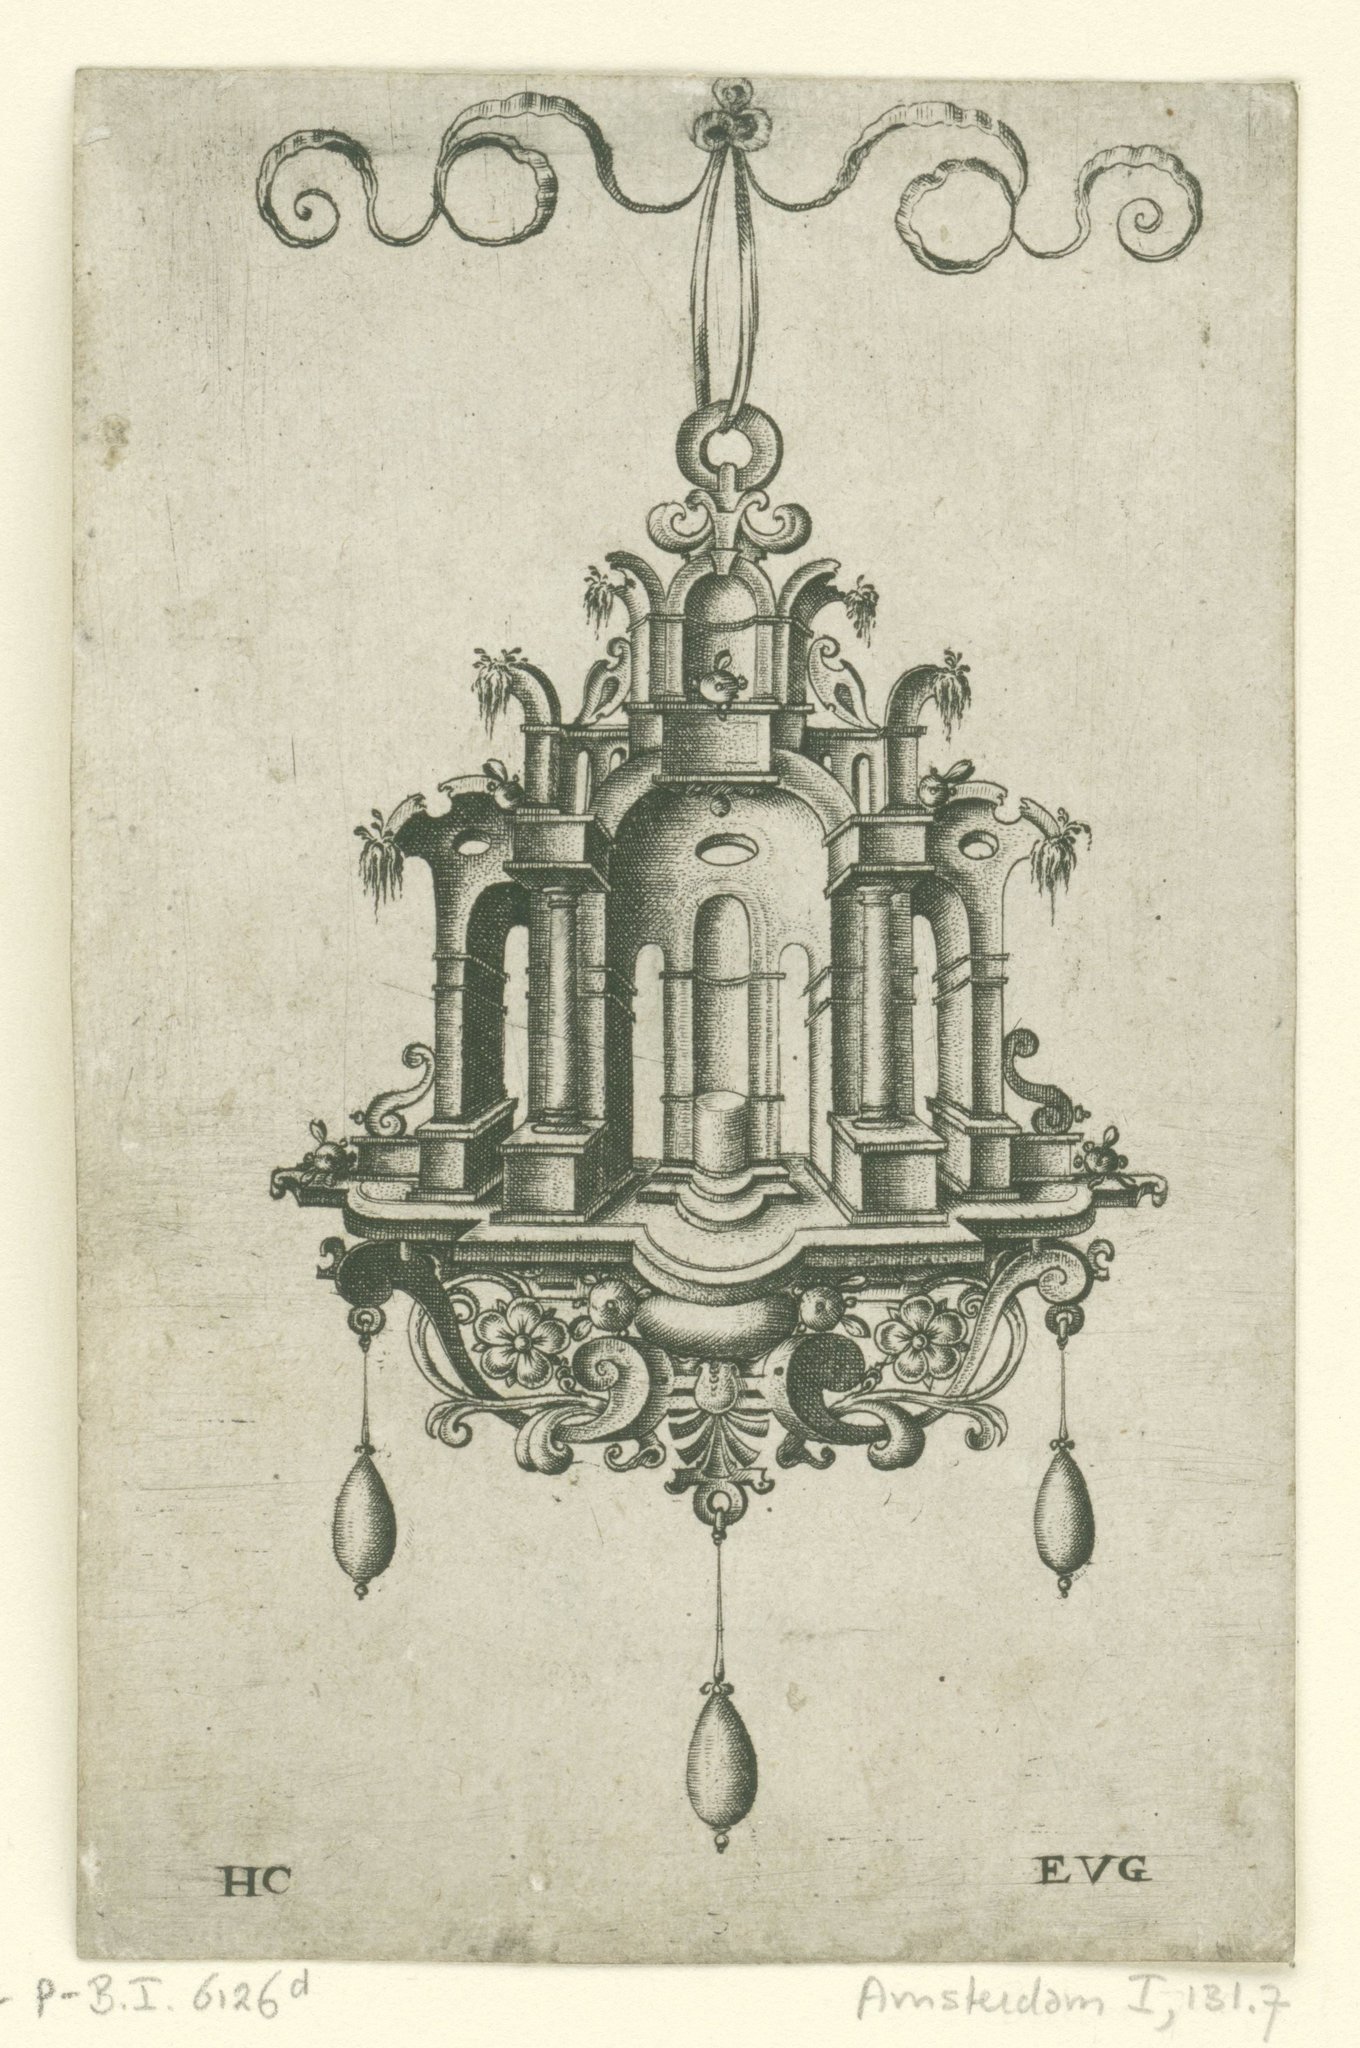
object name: ornament print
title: Hangers. Nissen, gedecoreerd met voluten van rol- en beslagwerk, mascarons, dieren en grotesken.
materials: paper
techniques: engraving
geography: netherlands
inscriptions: monogram: ‘HC’, collector's mark: Lugt 240, monogram: ‘EVG’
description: In het midden staat een rond leeg altaar op een verhoging. Eén van 9 bladen, uit een serie van 12. Op zes bladen zit in de nis een figuur. Aan elke hanger hangen drie parels.